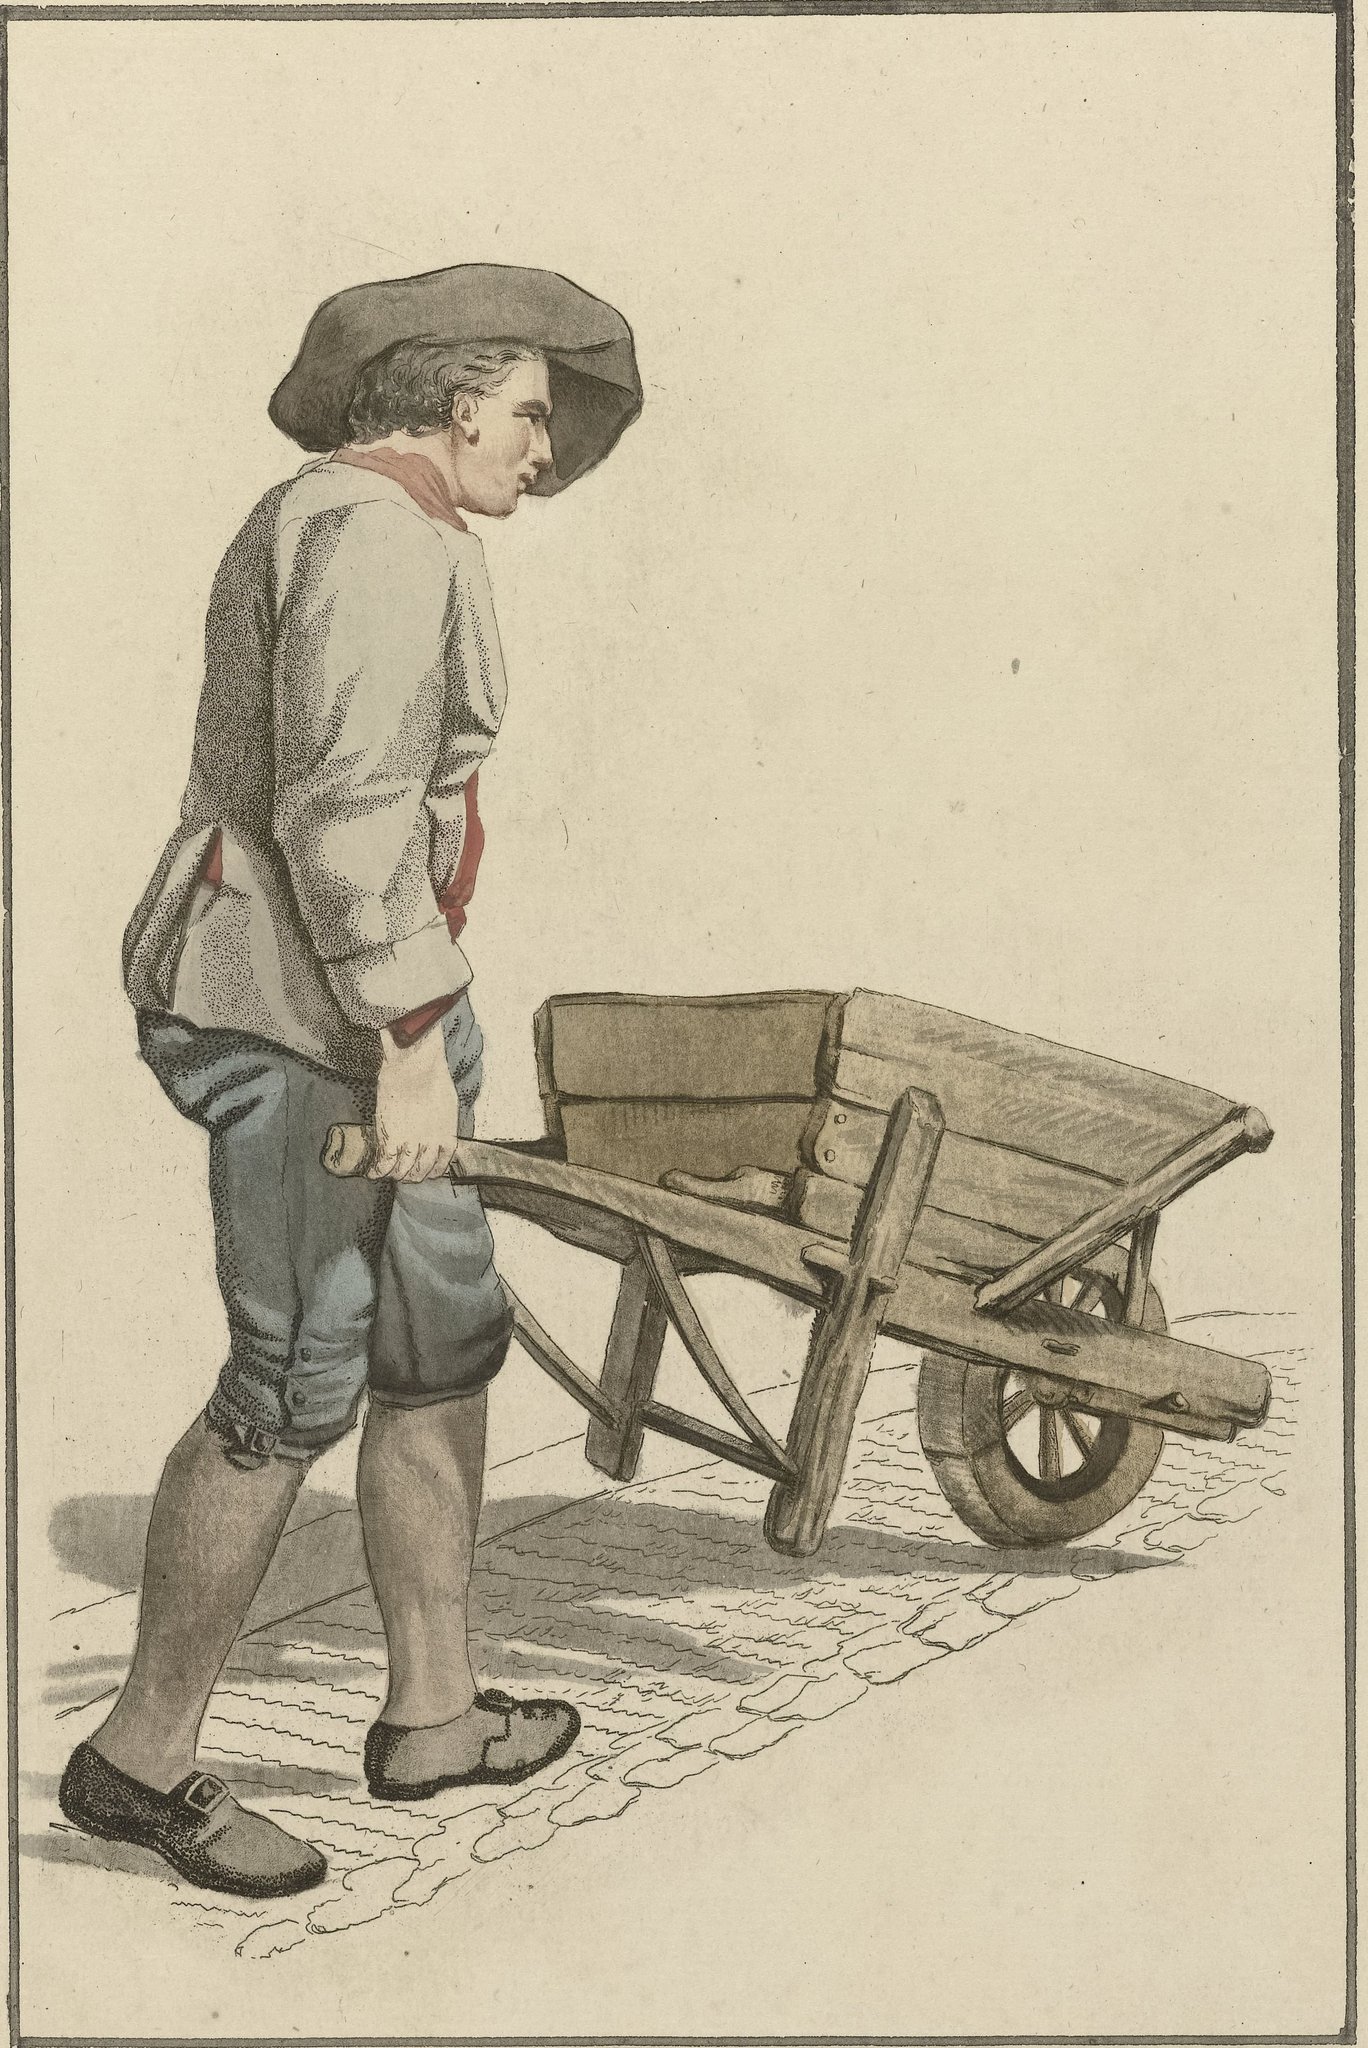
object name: print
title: Man met kruiwagen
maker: mathias de sallieth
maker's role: print maker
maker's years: 1749-1791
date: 1772-1791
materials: paper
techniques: aquatint, etching, hand coloring, lithography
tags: adult man, wheelbarrow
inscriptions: collector's mark: Lugt 2233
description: De prent verscheen vanaf 1818 tevens als onderdeel van een 33-delige reeks prenten door Mathias de Sallieth, samengebonden in: Perkois, Jacobus, Prins, Johannes Huibert. Verzameling van verschillende gekleede mans- en vrouwenstanden, ter oefening van jonge schilders en liefhebbers. Rotterdam: Johannes Immerzeel, 1818.